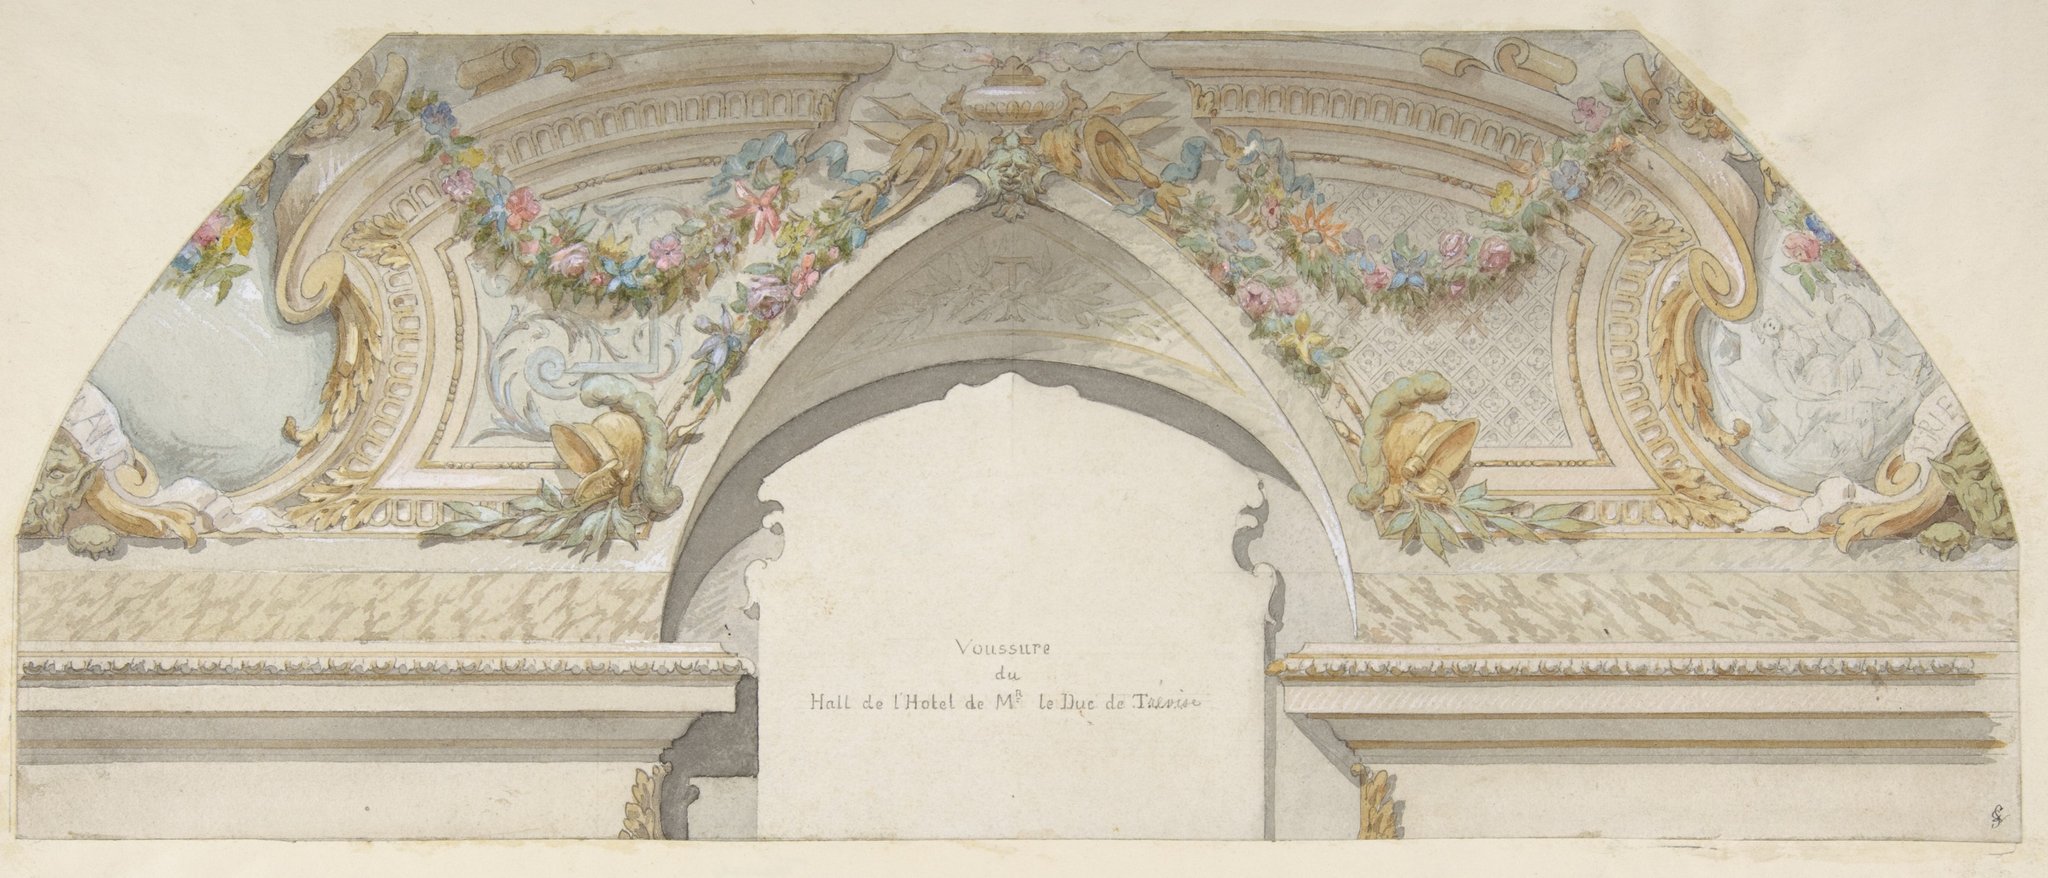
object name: drawing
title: Design for Hôtel de Trevise, Paris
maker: jules-edmond-charles lachaise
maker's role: artist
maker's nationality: french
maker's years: 1897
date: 1851-1900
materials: ink, watercolor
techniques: heightening, pen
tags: architecture,garlands